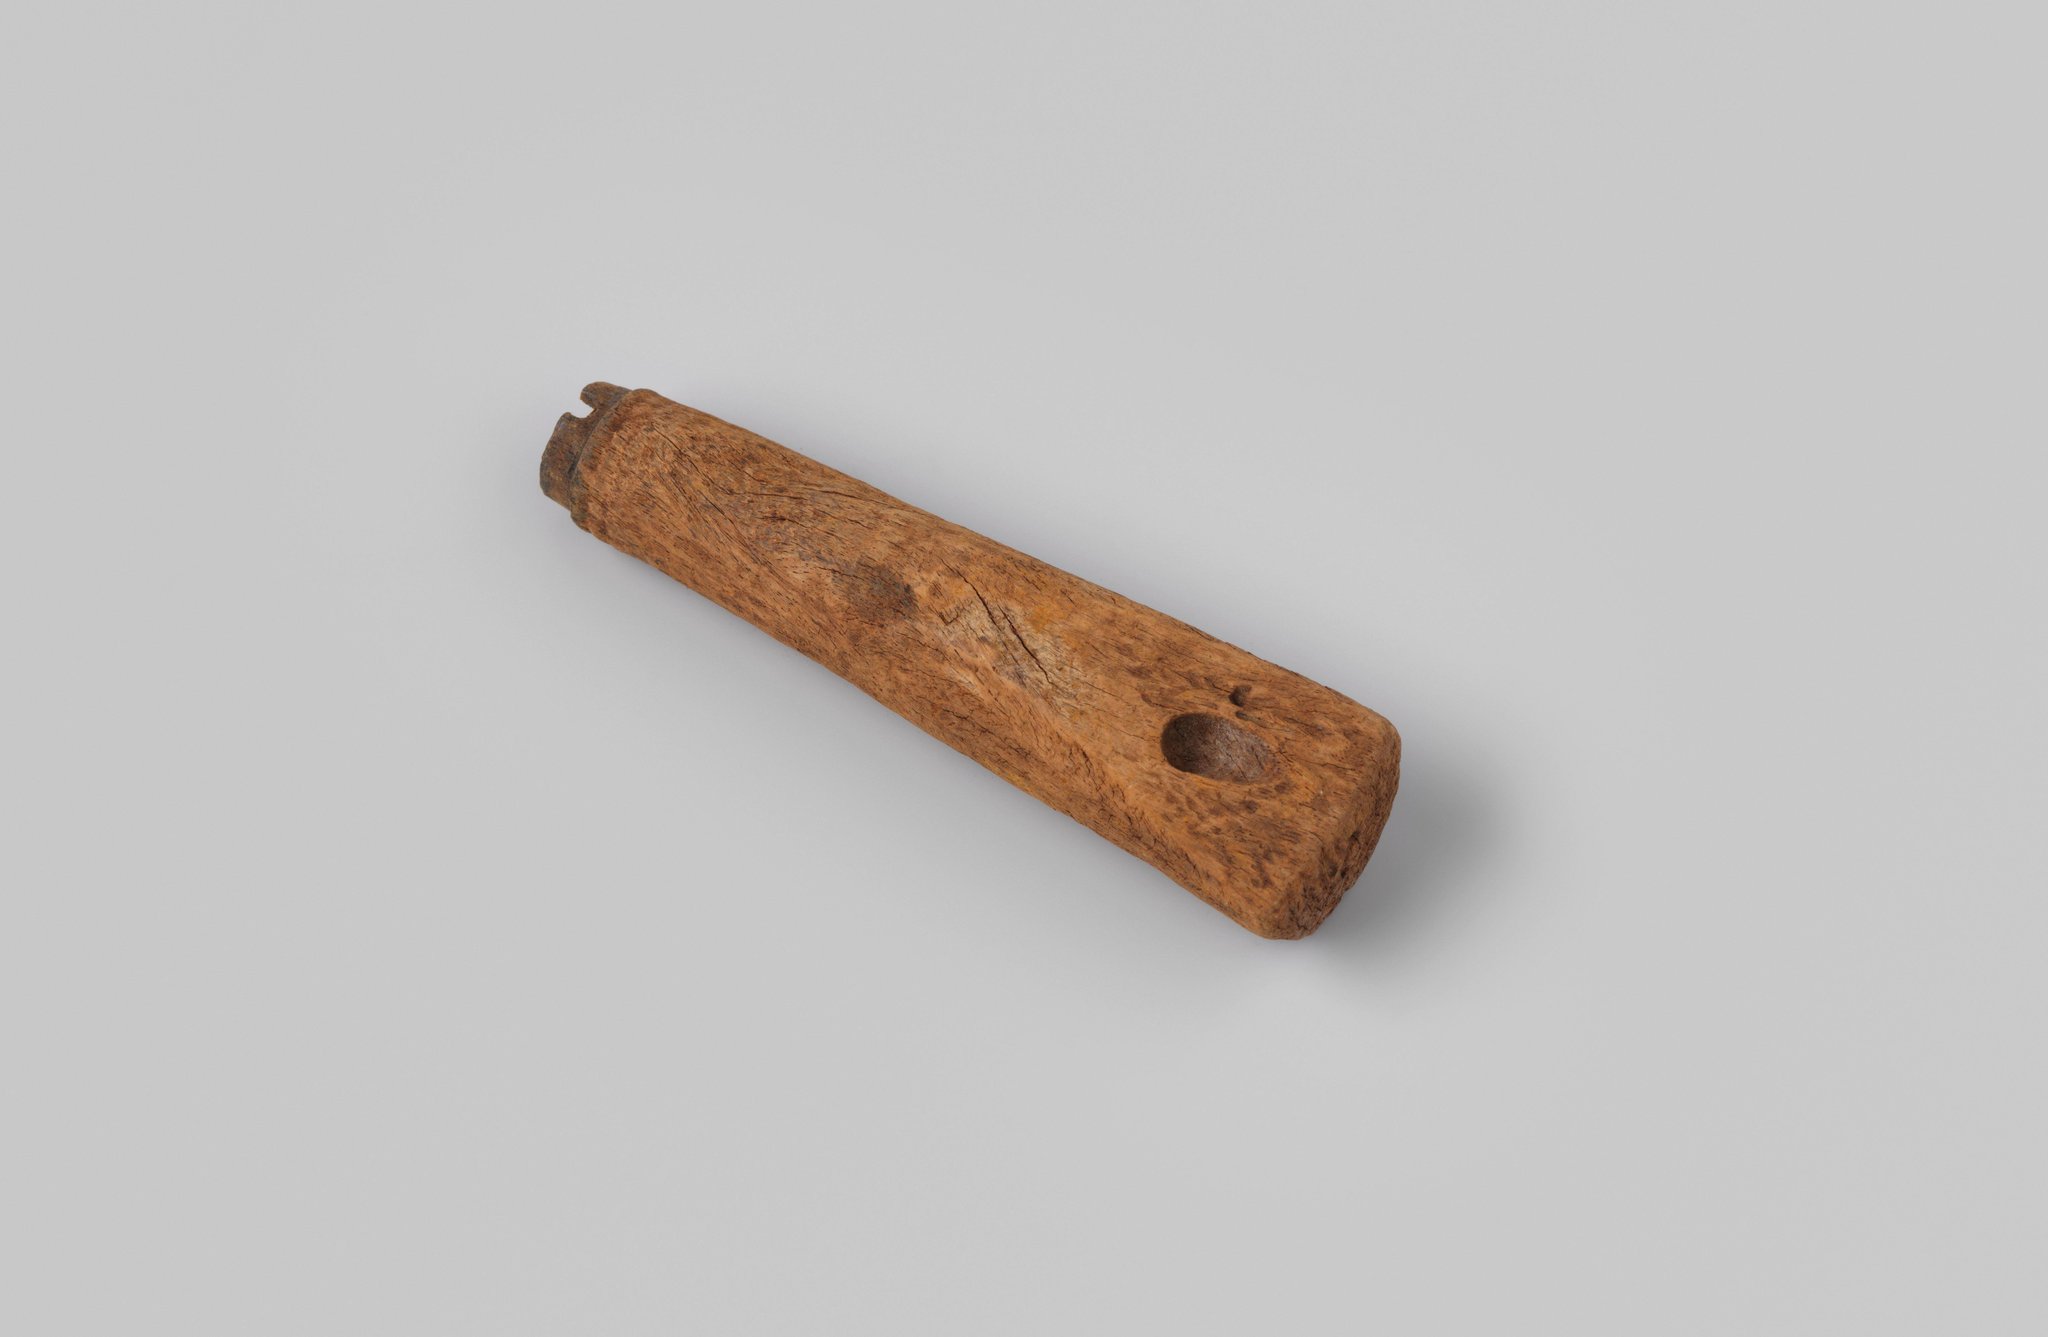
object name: knife handle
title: Messenheft uit het wrak van de Oost-Indiëvaarder Hollandia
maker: Anonymous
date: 1700-1743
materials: wood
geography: netherlands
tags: verenigde oostindische compagnie, hollandia (schip), annet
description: Knife, handle, cylindrical: tapering; id. NG 1979-403H, ferrules id. NG 1980-27H426.